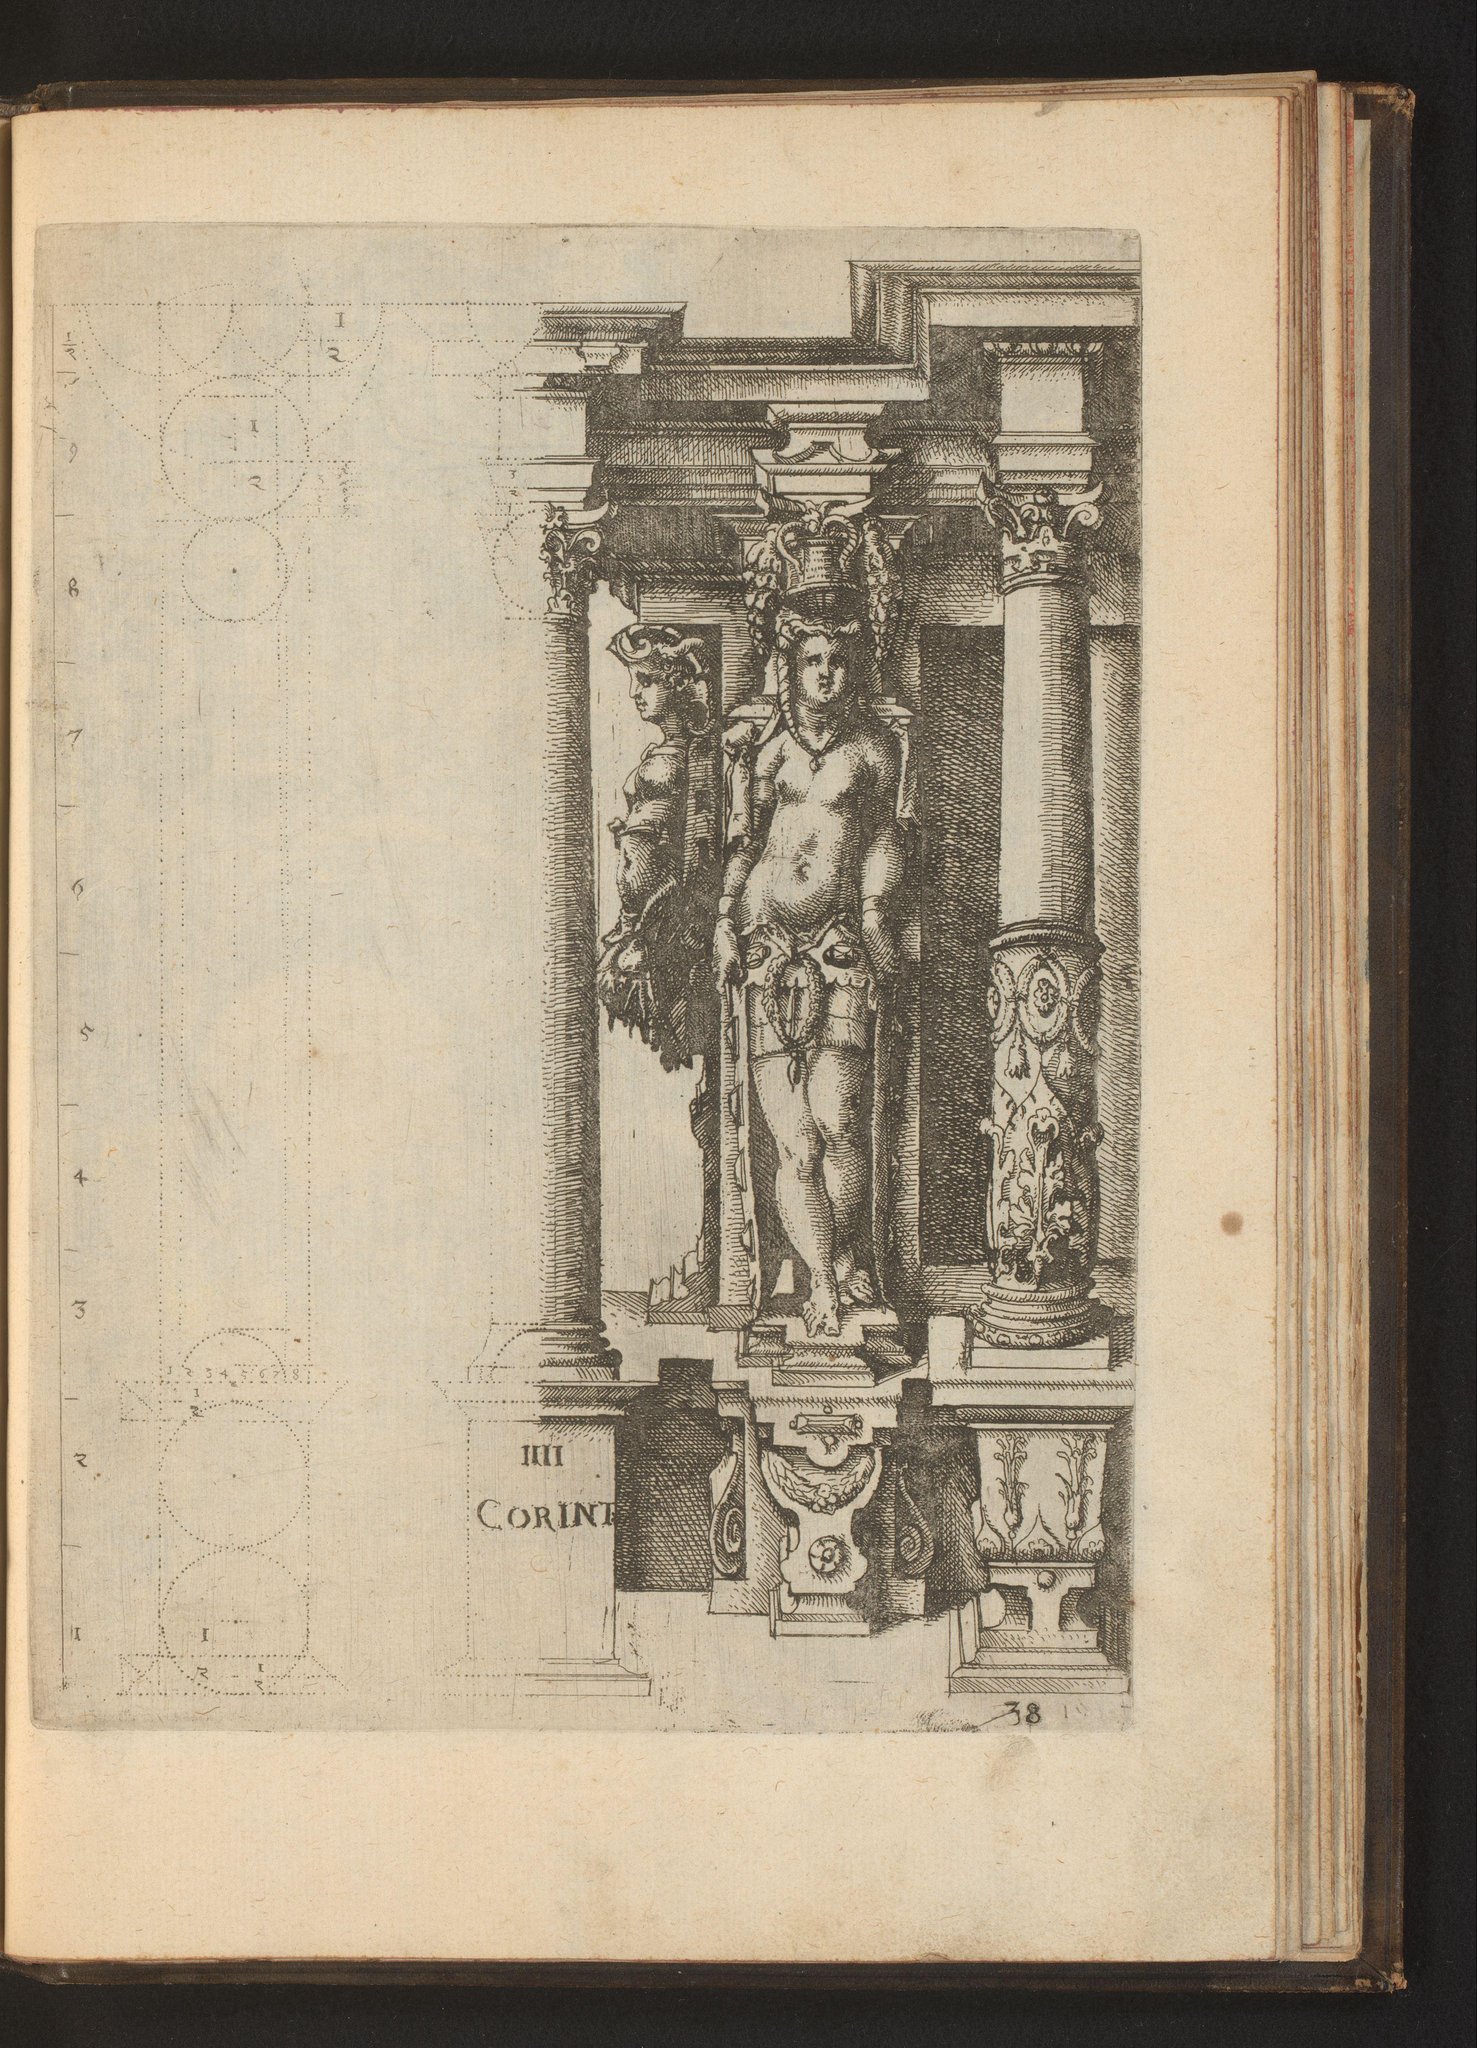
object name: book illustration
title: Verhoudingen van de Korinthische zuilenorde met een kariatide en een herme van opzij gezien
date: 1593-1595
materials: paper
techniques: etching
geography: straatsburg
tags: column, pillar ~ architecture, pedestal of a piece of sculpture (perhaps in the form of a herm) (+ architecture), other architectural details, corinthian order ~ architecture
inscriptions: collector's mark: Lugt 2760, collector's mark: Lugt 2228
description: Prent gebruikt in: Dietterlin, Wendel (I). Wendel Dietterlin, Architectura de Polstium seu Portalium ornatu uario Liber II. Straatsburg: Bernhard Jobin, 1594.